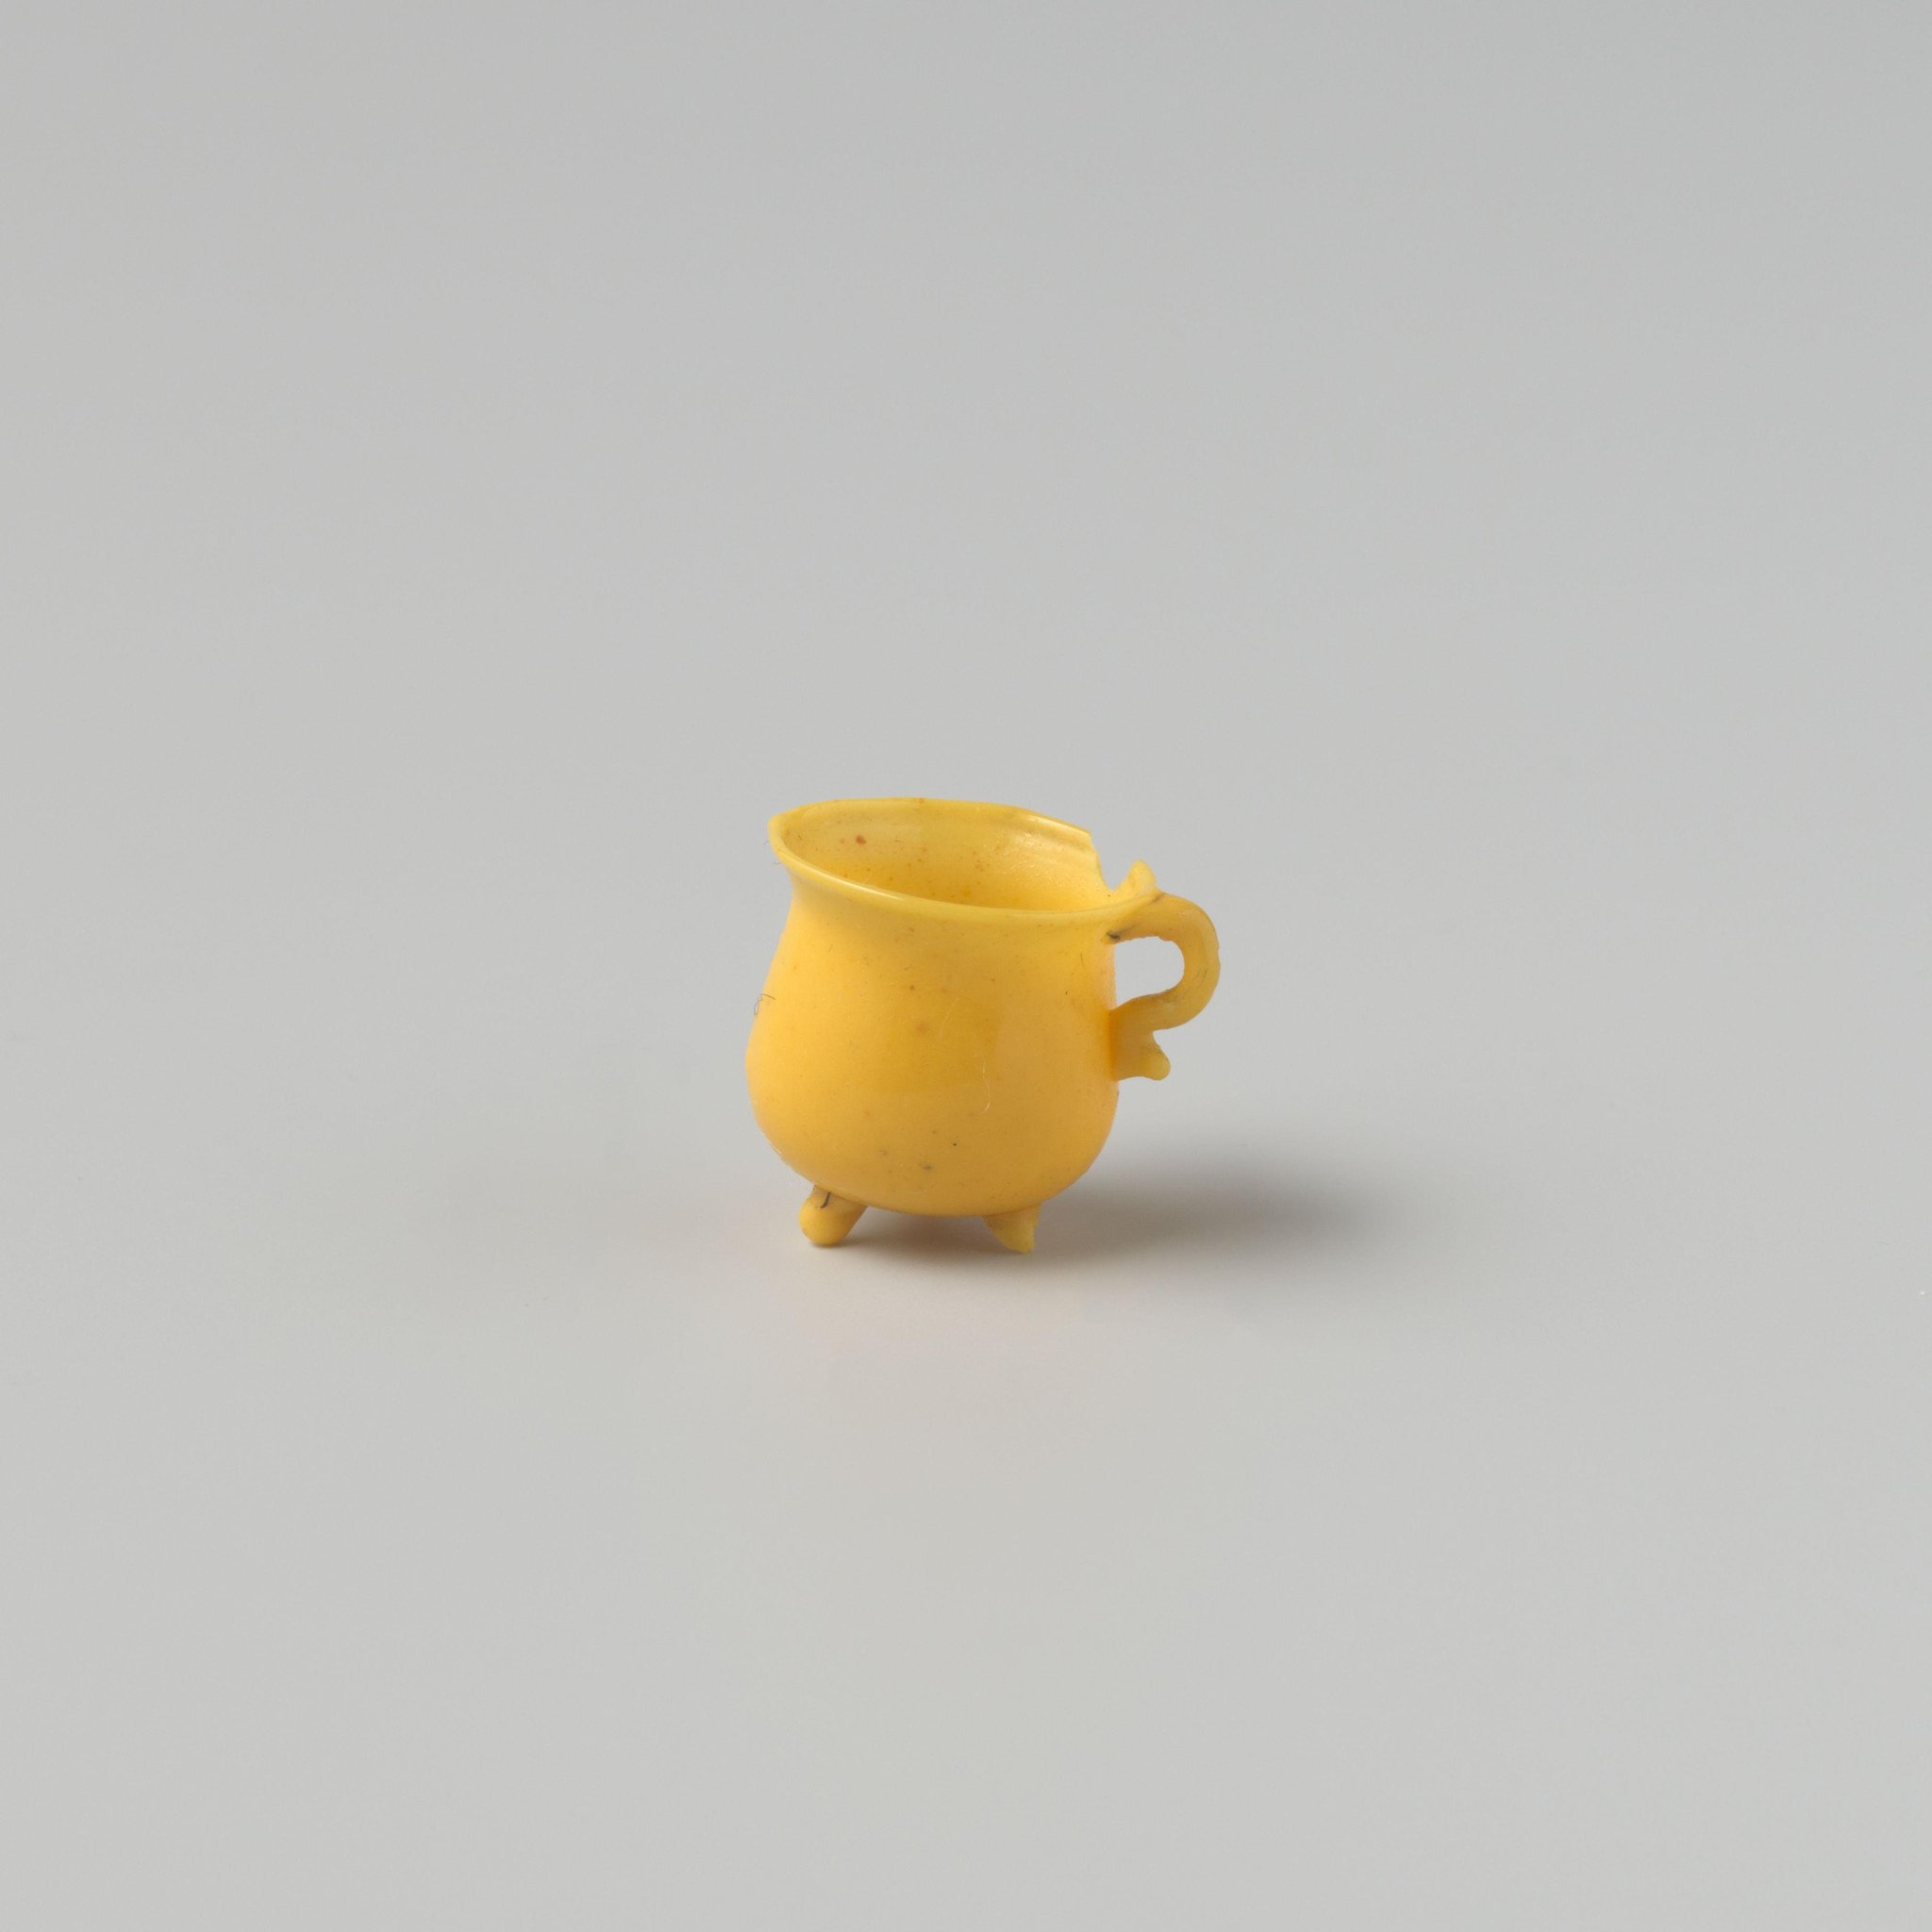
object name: cauldron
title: Kookkan van opaak geel glas (waarschijnlijk imitatie geel aardewerk); op drie pootjes met schenklip en oor.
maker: Anonymous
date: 1675-1710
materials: glass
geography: amsterdam